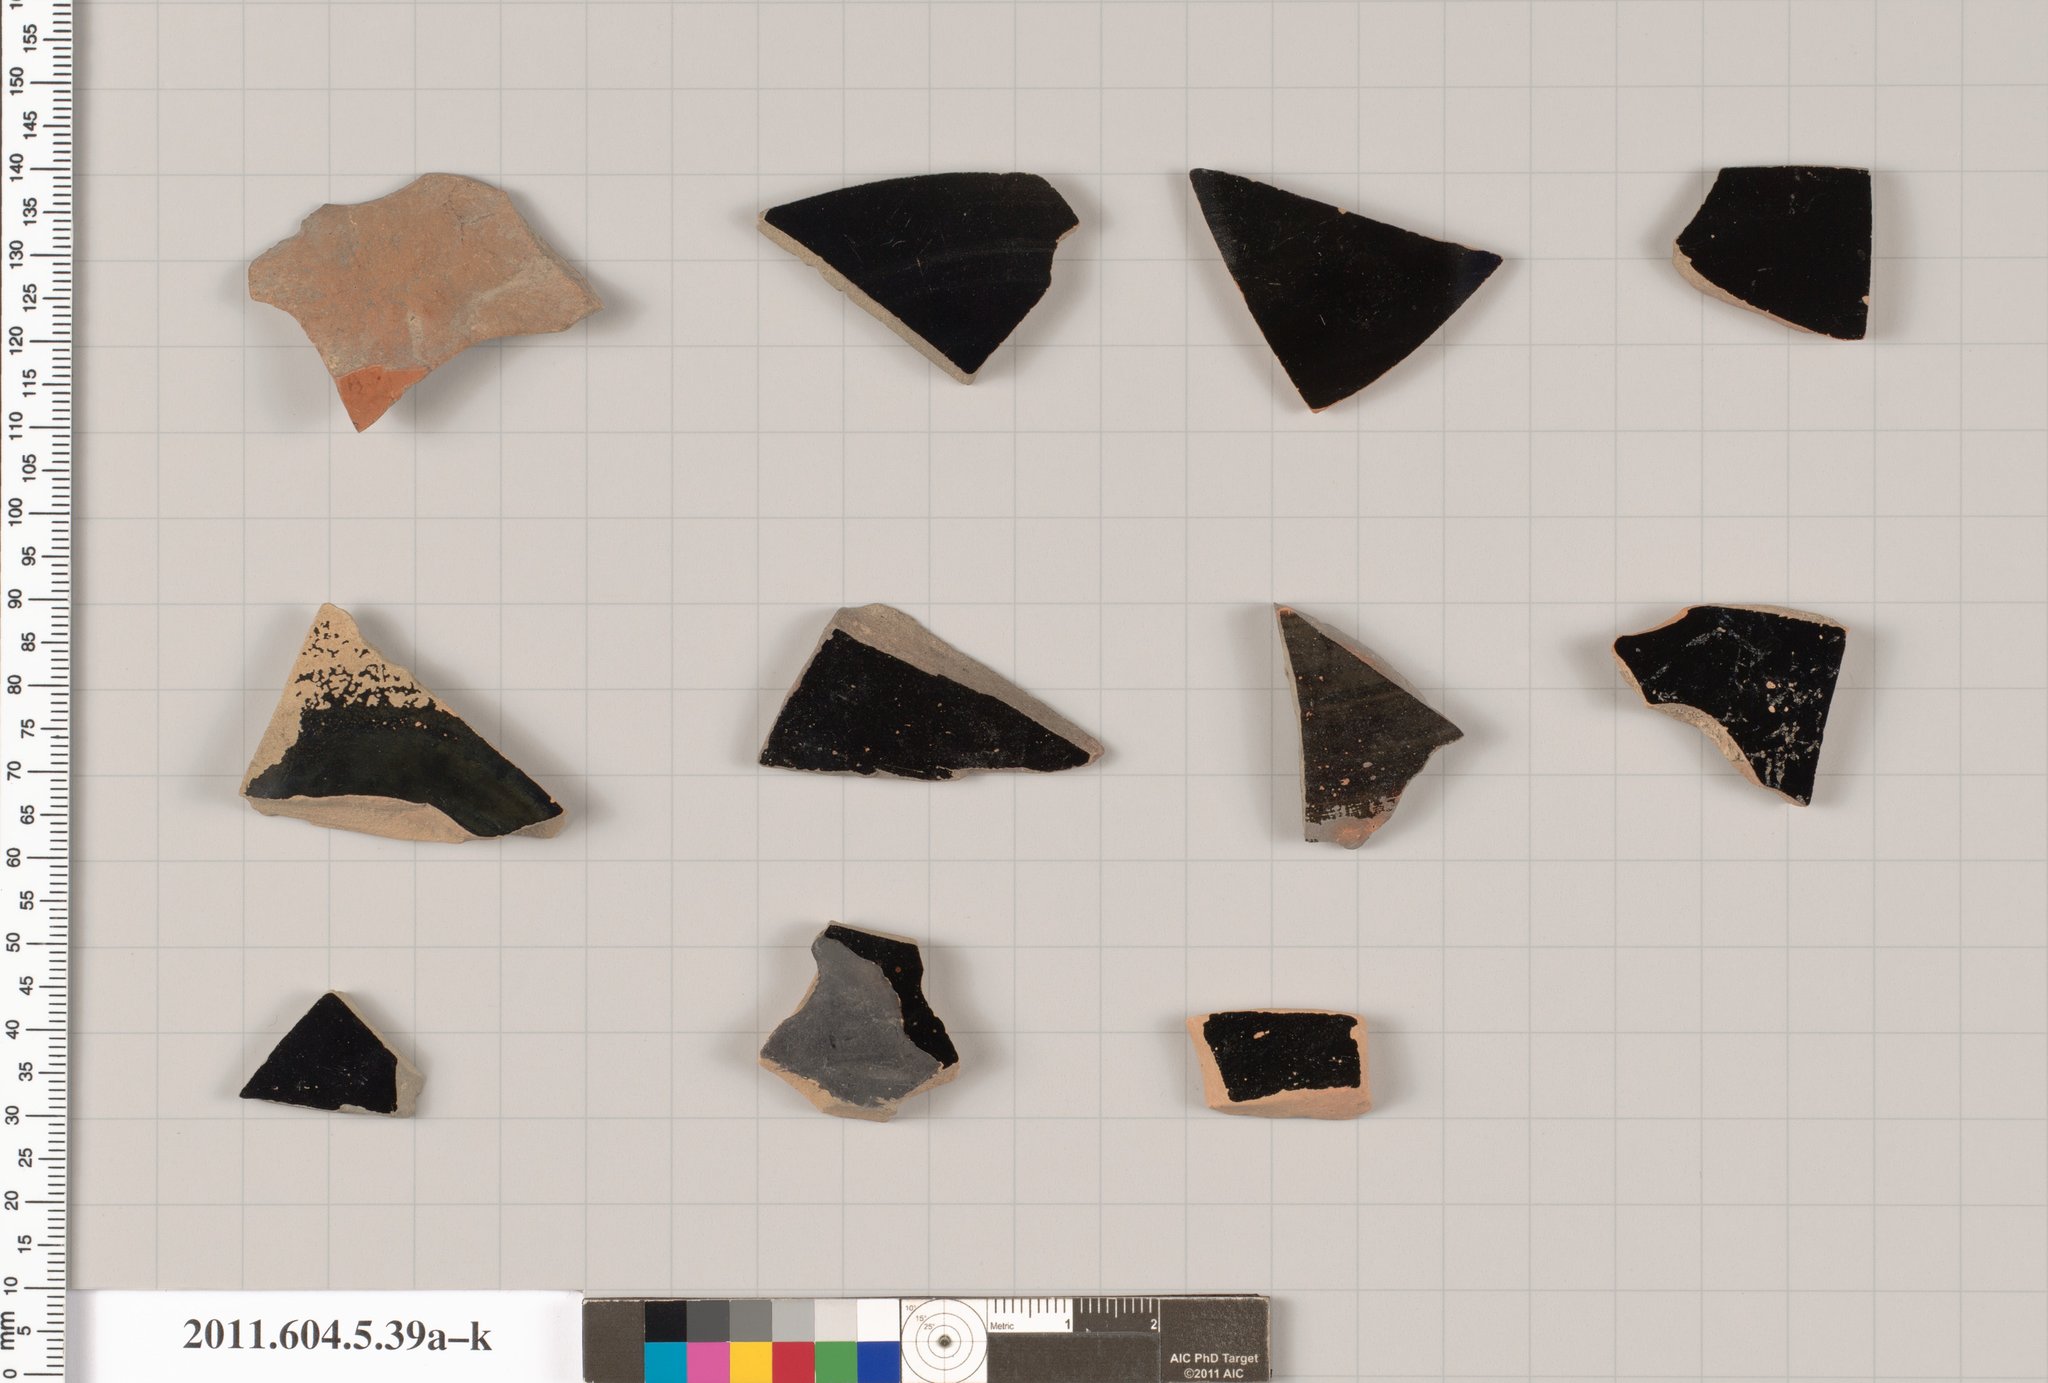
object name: kylix fragment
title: Terracotta fragments of kylikes (drinking cups)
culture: greek, attic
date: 500-401 BCE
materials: terracotta